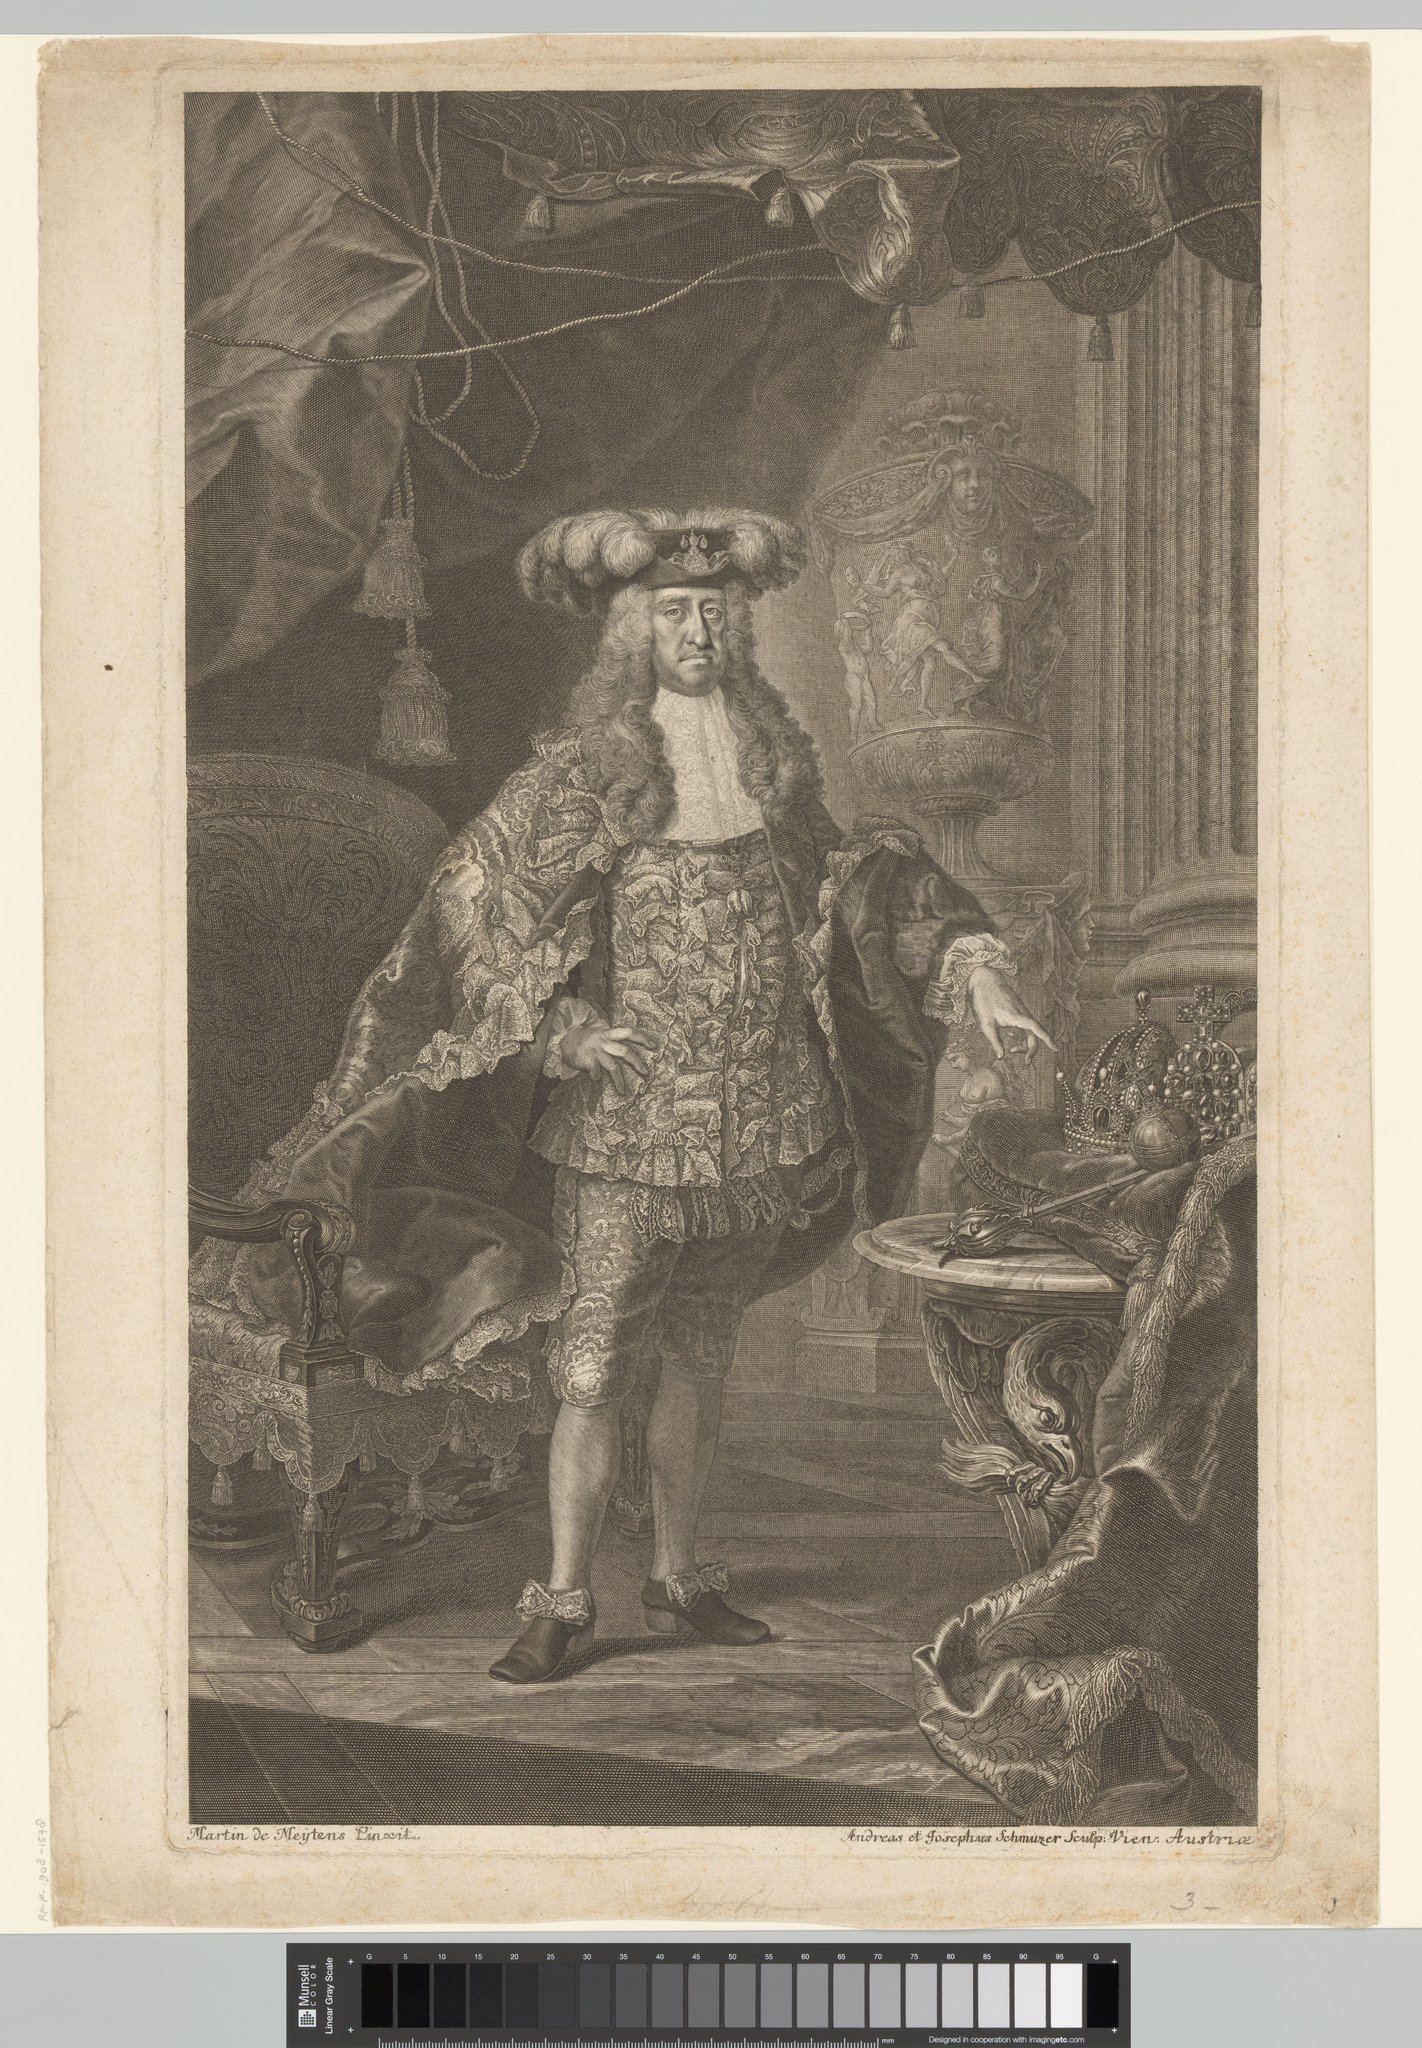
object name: print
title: Portret van keizer Karel VI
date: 1710-1740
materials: paper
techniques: engraving, etching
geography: vienna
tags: vienna, charles vi (holy roman emperor), historical persons, insignia and symbols of sovereignty (crown, diadem, sceptre, orb, seal, standard, cloak, pectoral)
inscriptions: collector's mark: Lugt 2228